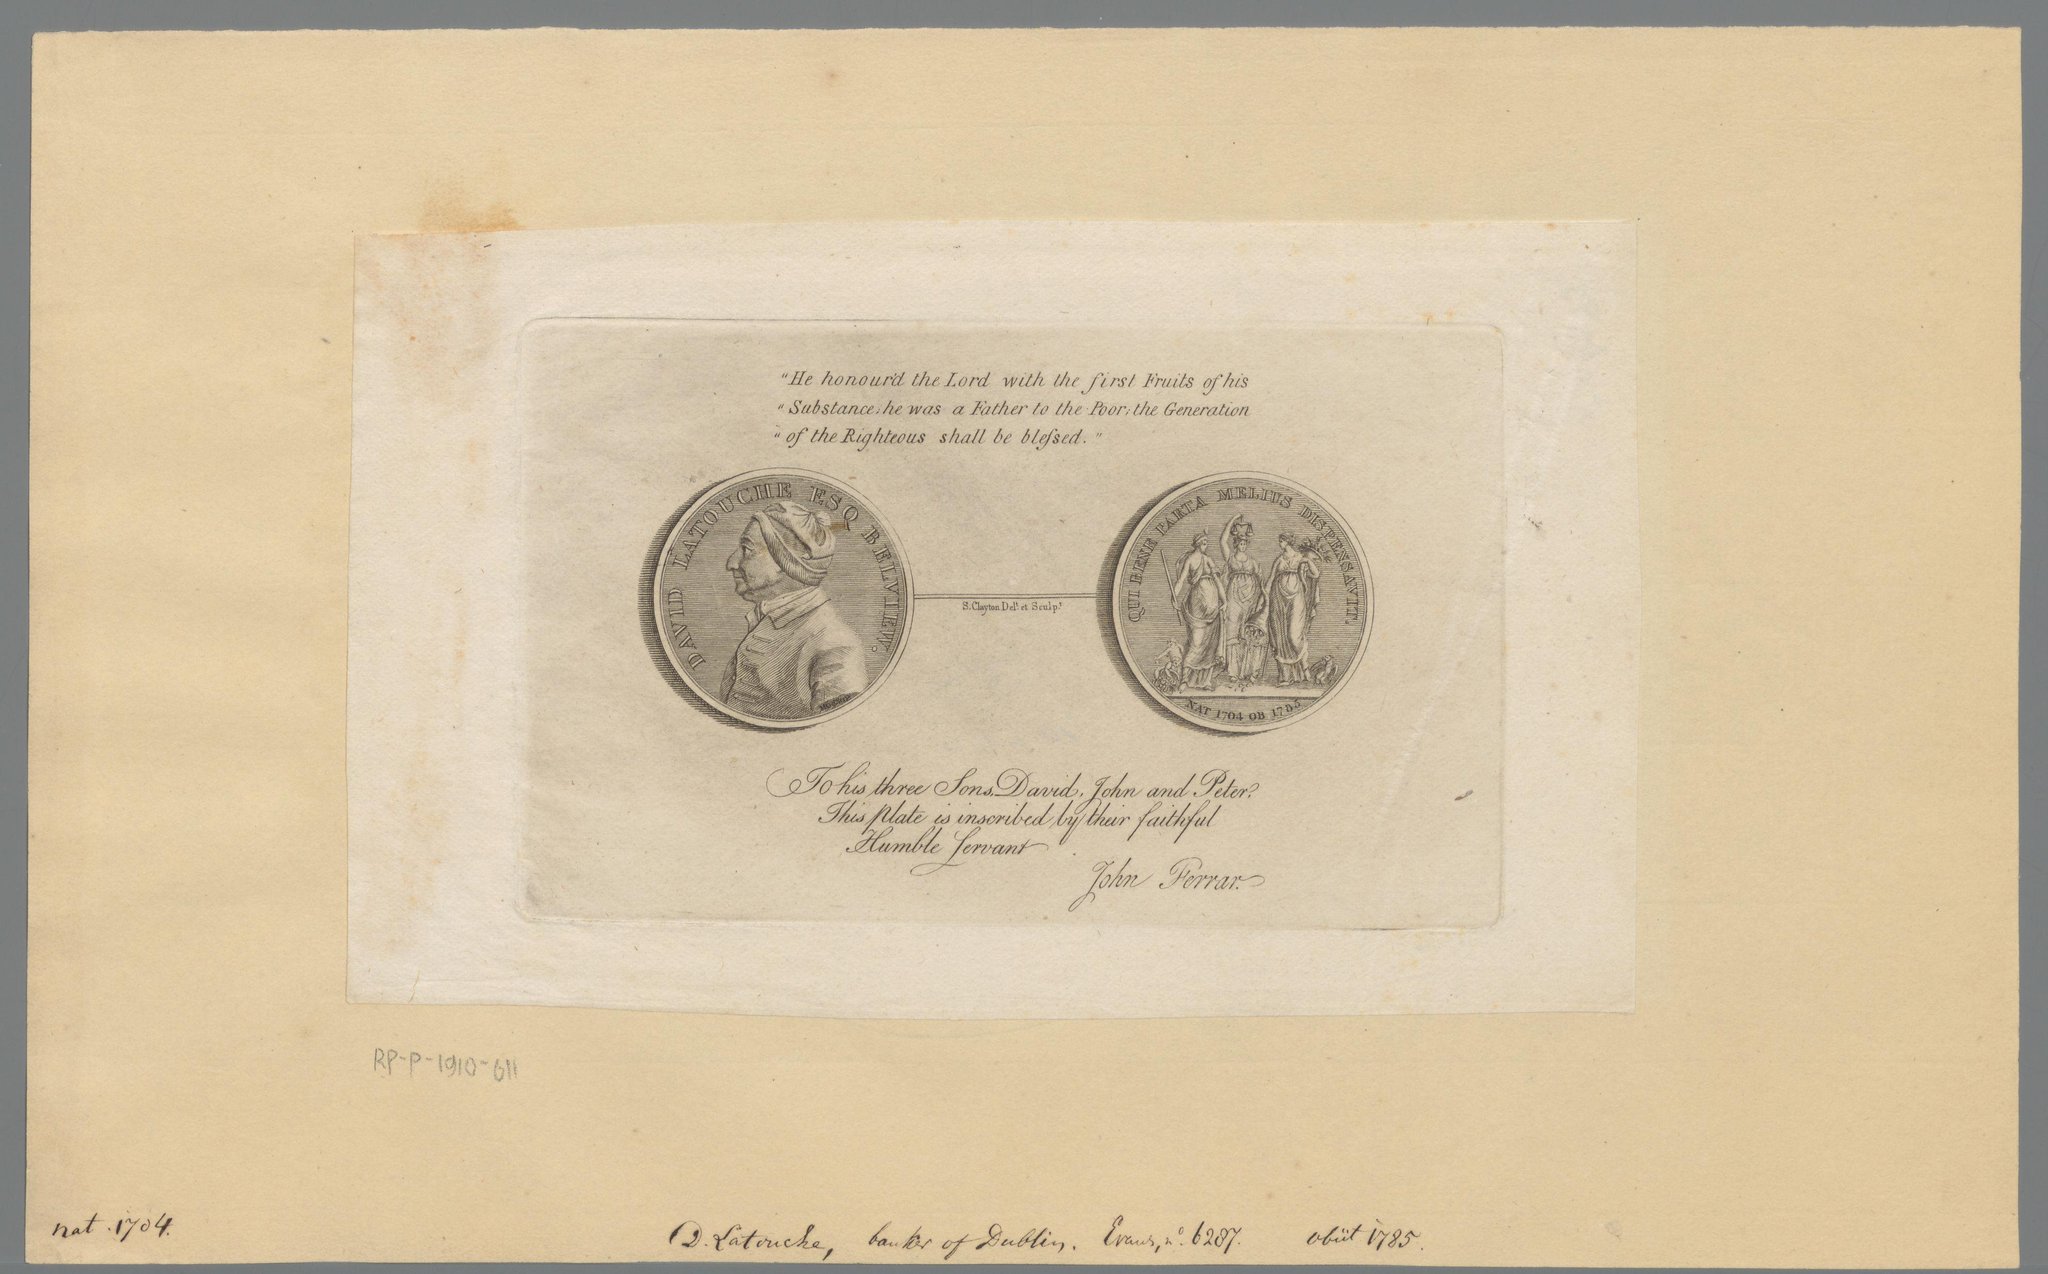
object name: print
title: Portret van David Latouche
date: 1775-1875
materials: paper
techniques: etching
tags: politician, trade token, private coin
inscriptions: collector's mark: Lugt 2228, annotation: ‘D. Latouche, (...) of Dublin. (...) 6278. obiit 1785’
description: Het portret geeft één zijde van een erepenning weer, met aan de andere kant de drie gratiën. De munt is opgedragen aan de drie zoons van David Latouche: David, John en Peter.